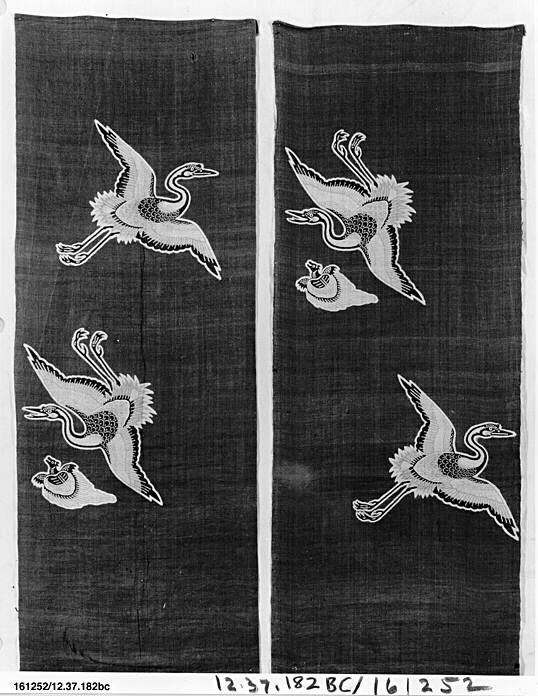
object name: cover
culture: japanese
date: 1801-1900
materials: textile, dye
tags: geese